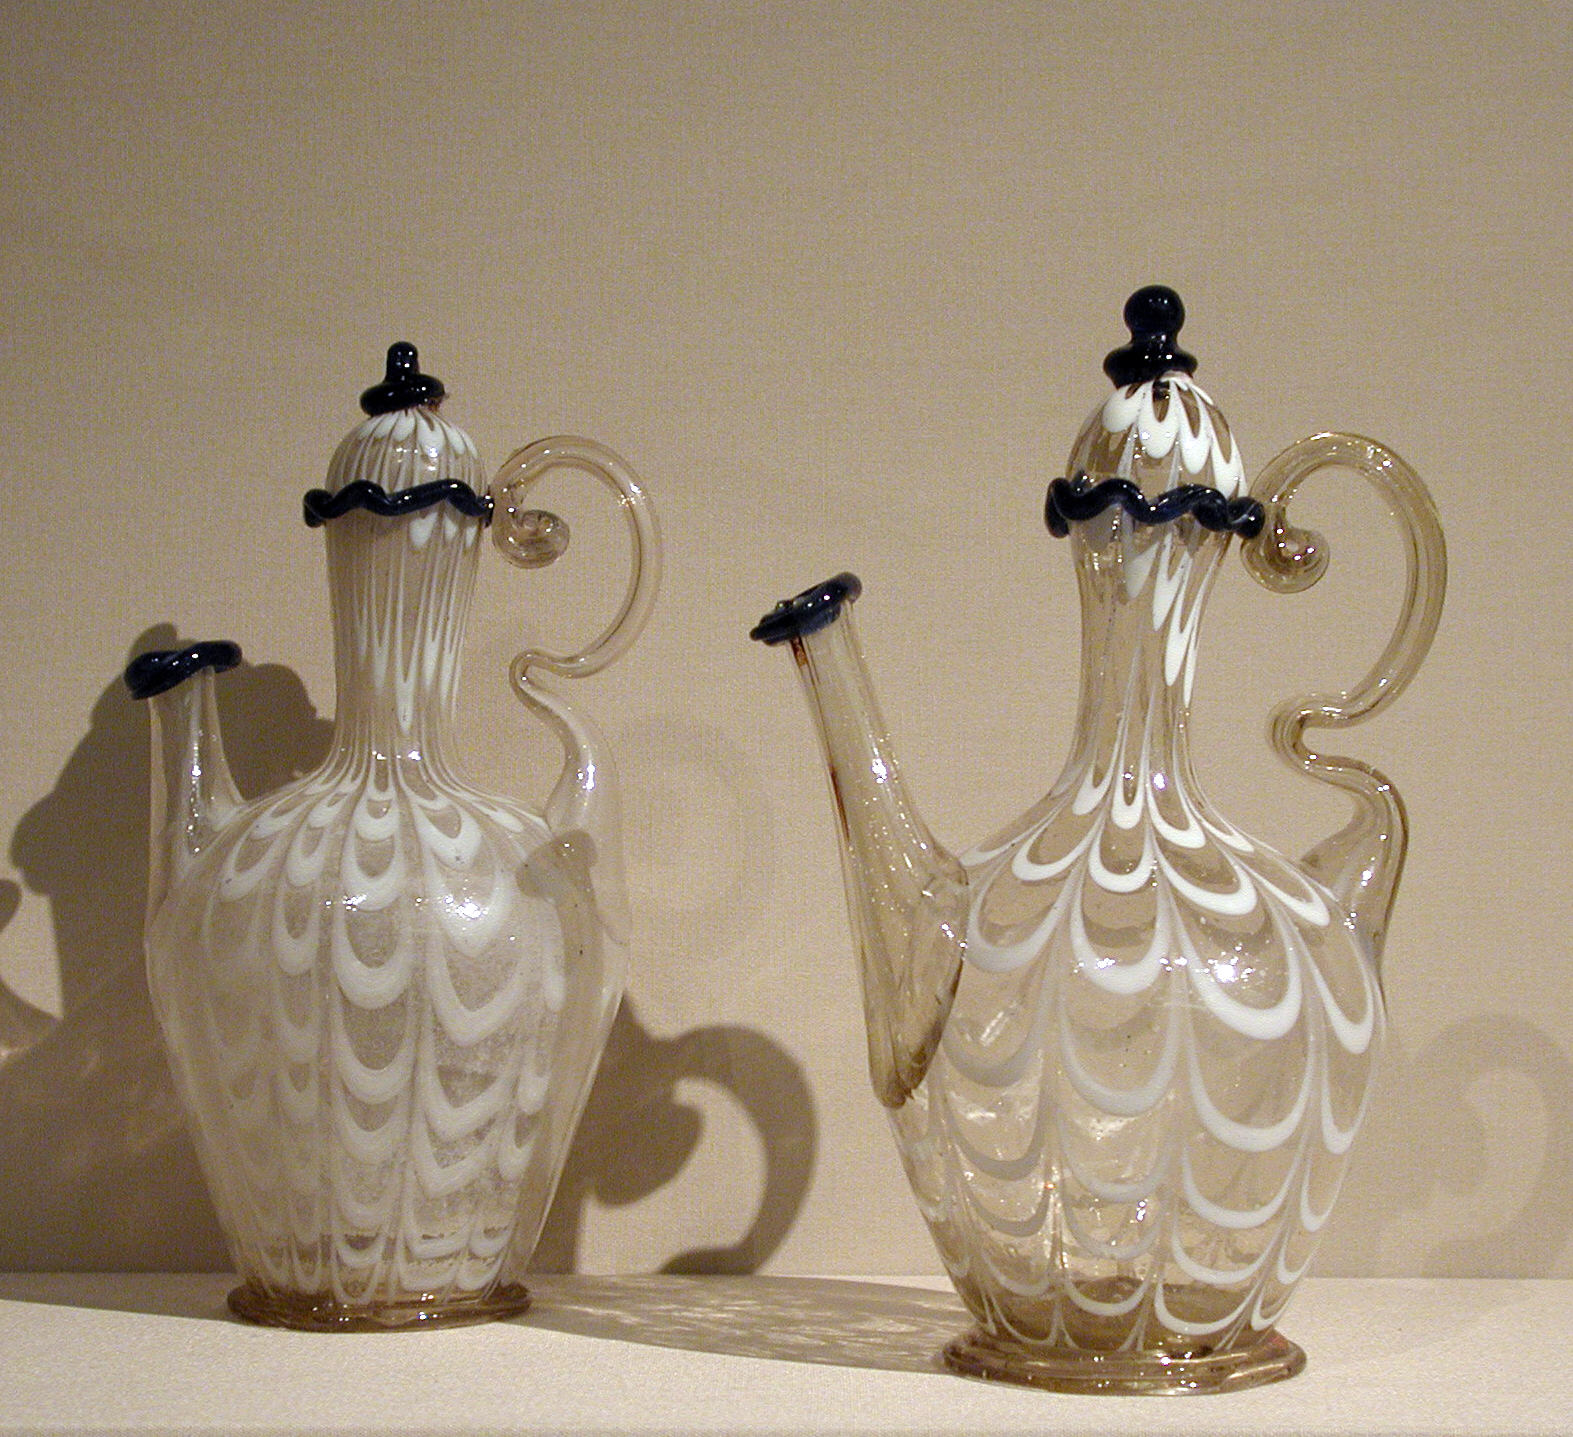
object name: biberon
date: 1501-1700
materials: glass